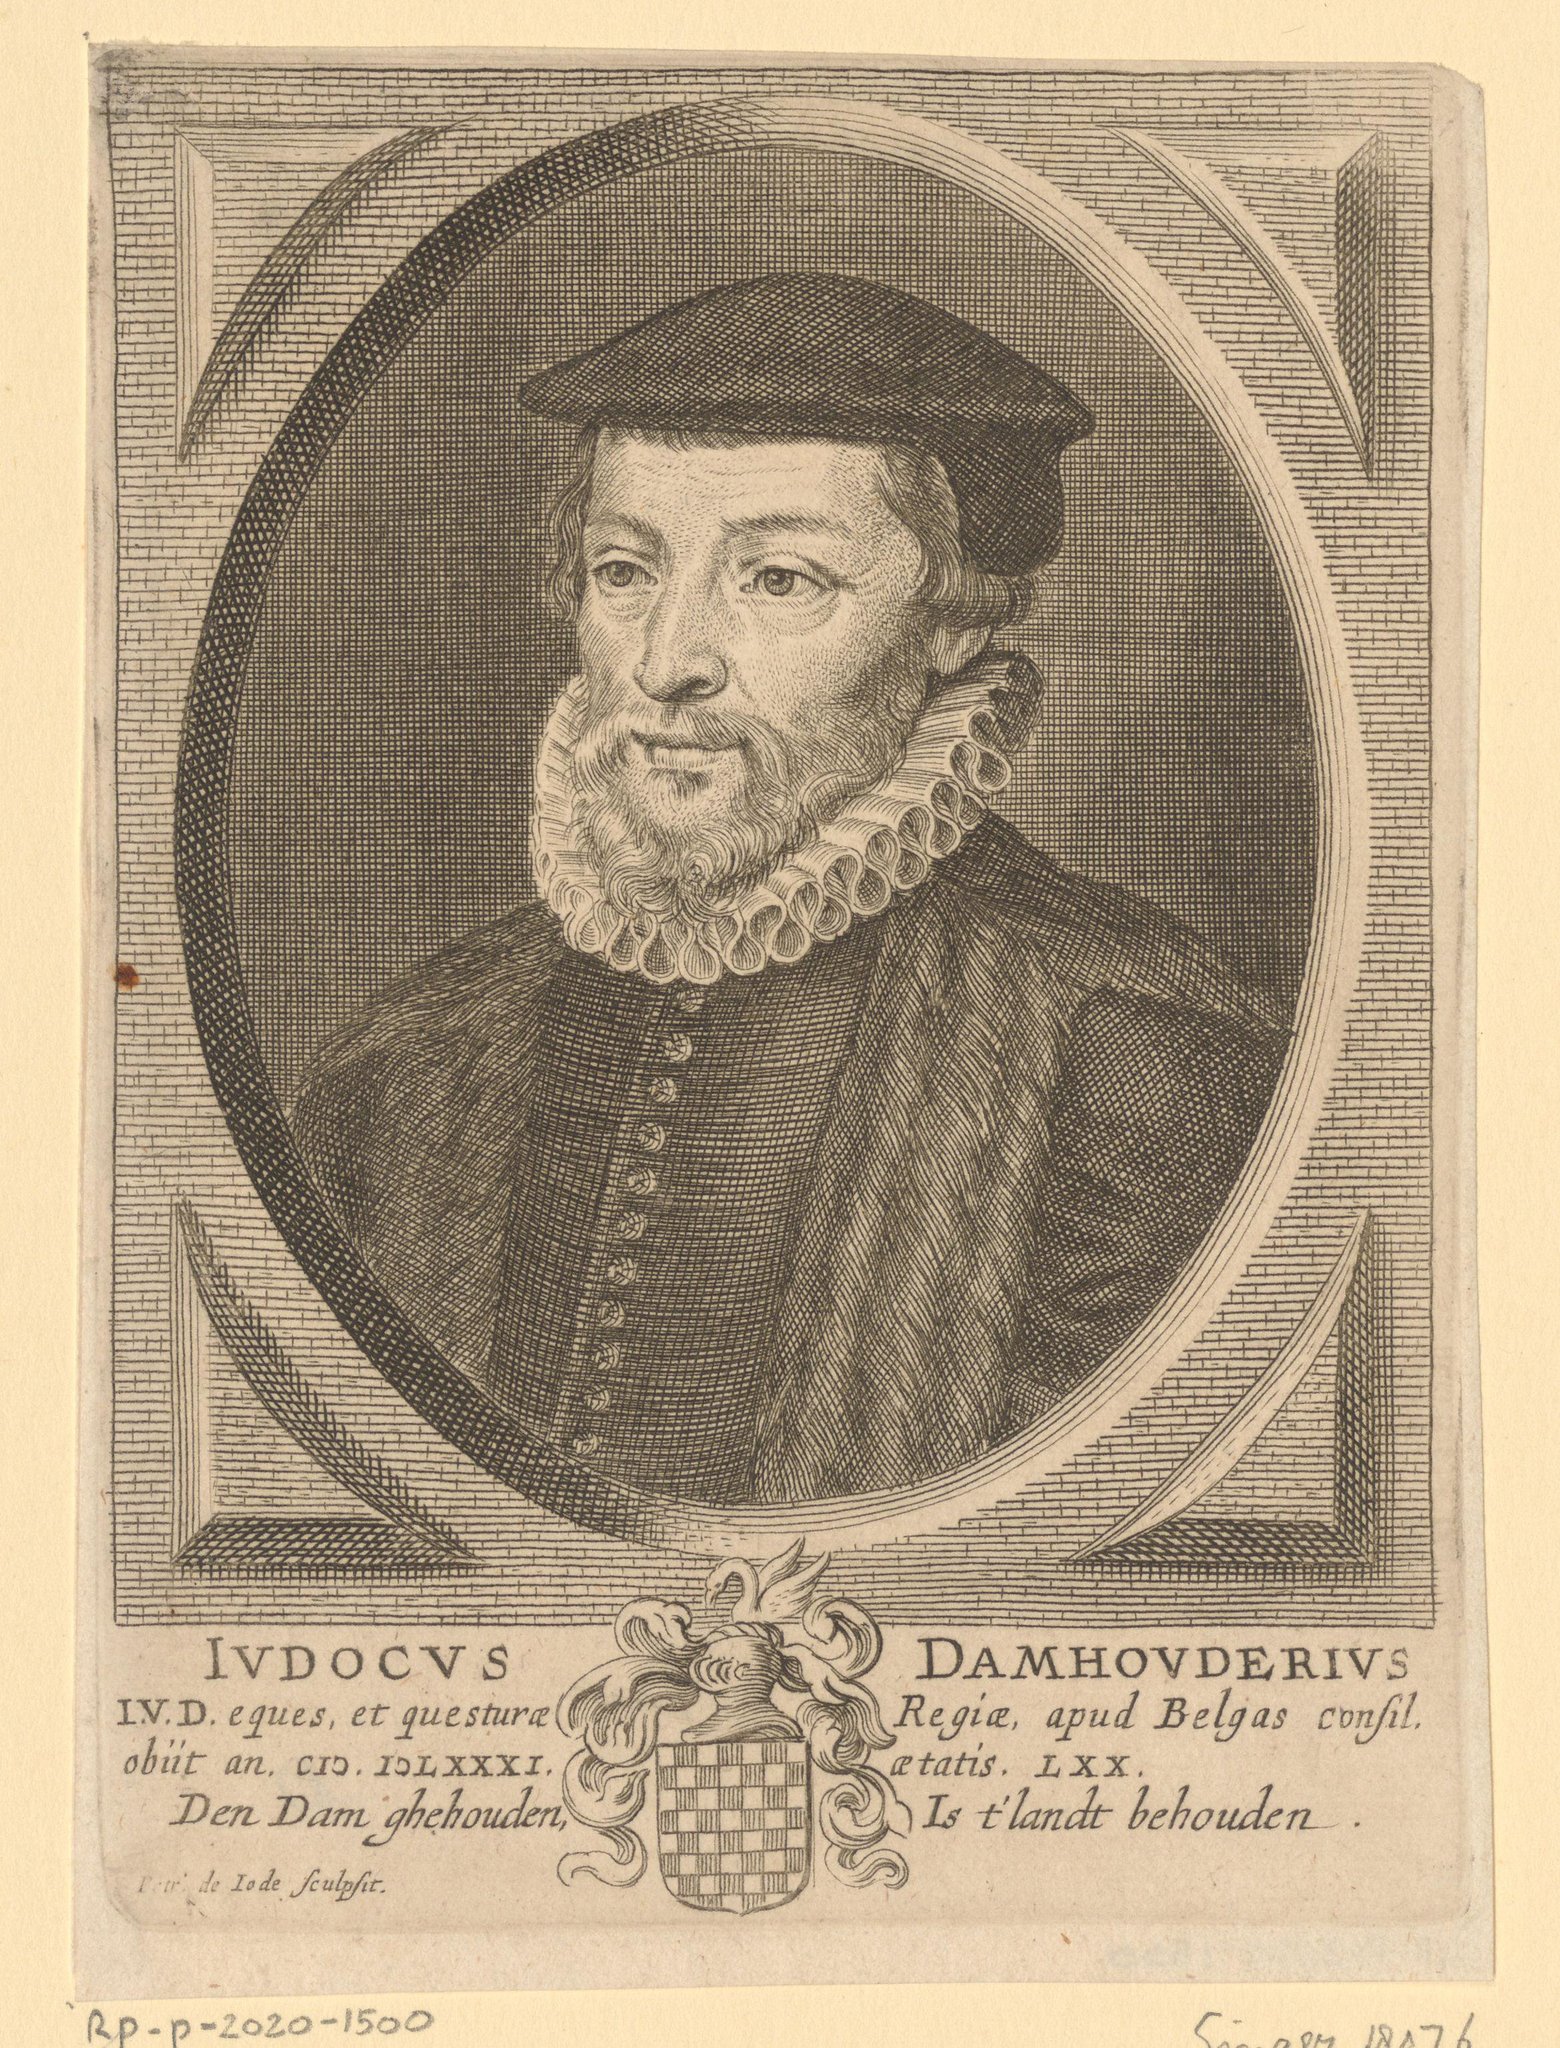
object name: print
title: Portret van Joos de Damhouder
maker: pieter de jode (ii)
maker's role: draughtsman, print maker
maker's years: 1606-1674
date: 1628-1670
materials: paper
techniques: engraving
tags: bruges, antwerp, historical persons, counsellor, portrait of a writer